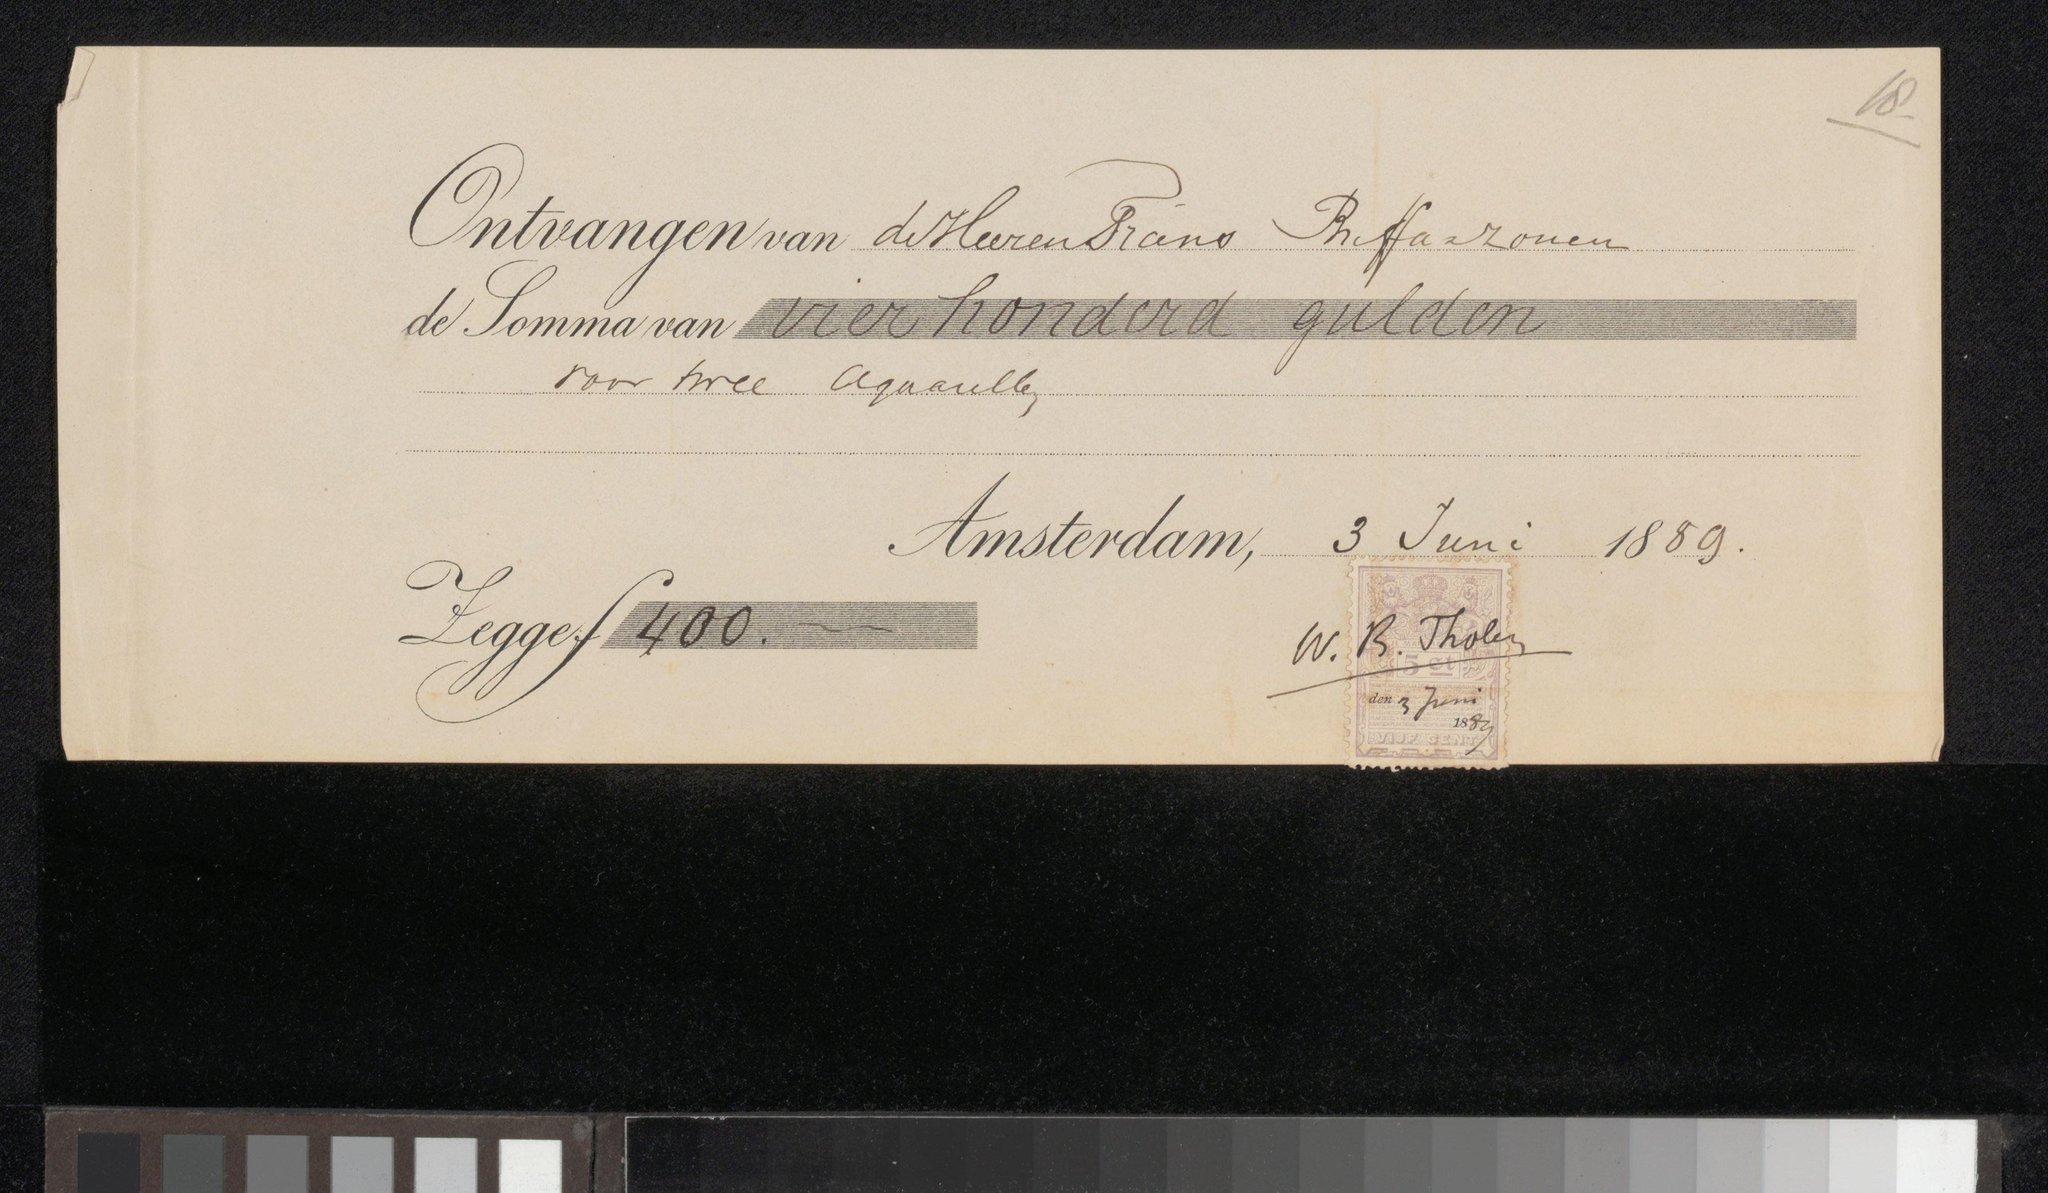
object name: ontvangstbewijs, kwitantie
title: Kwitantie voor Willem Bastiaan Tholen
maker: willem bastiaan tholen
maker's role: draughtsman, painter, print maker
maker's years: 1860-1931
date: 1889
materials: ink, paper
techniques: pen, printing, writing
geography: amsterdam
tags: drawing, money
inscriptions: collector's mark: Lugt 2233